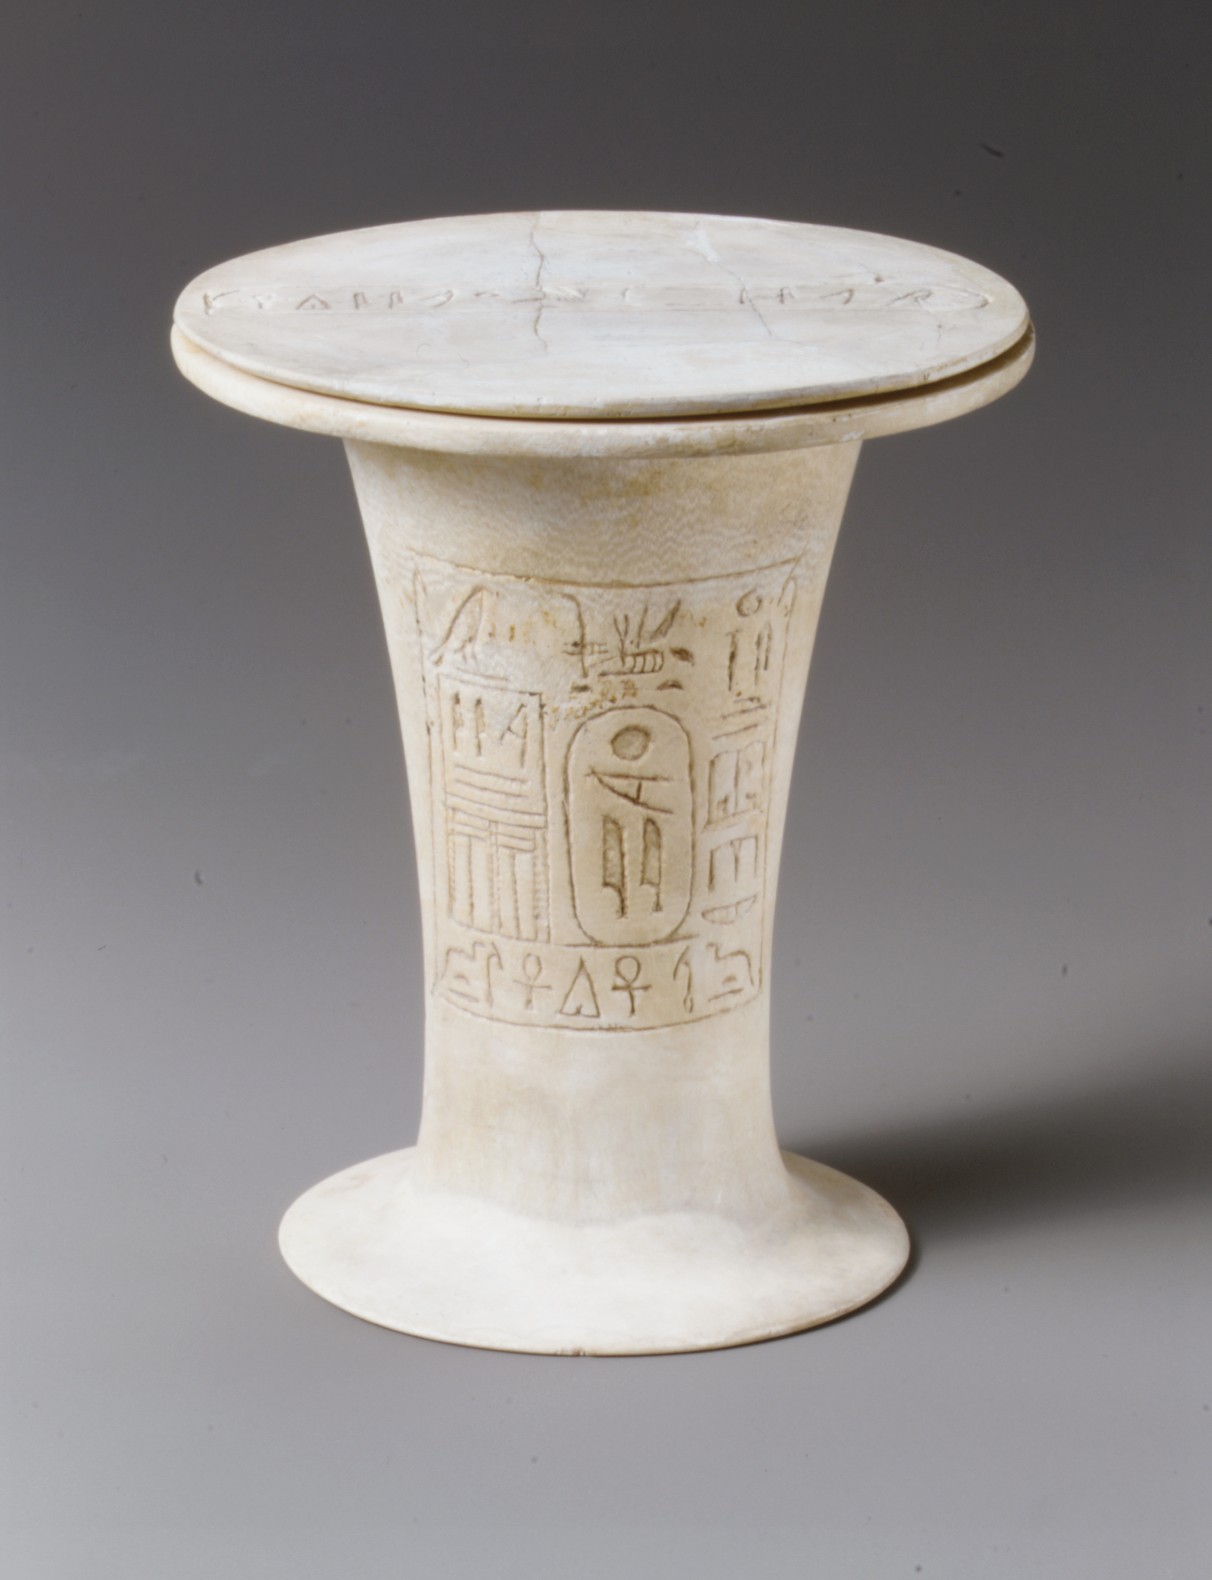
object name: ointment jar, pepi i, sed, festival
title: Ointment jar inscribed with the name of Pepi I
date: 2289-2255 BCE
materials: stone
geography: egypt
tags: hieroglyphs